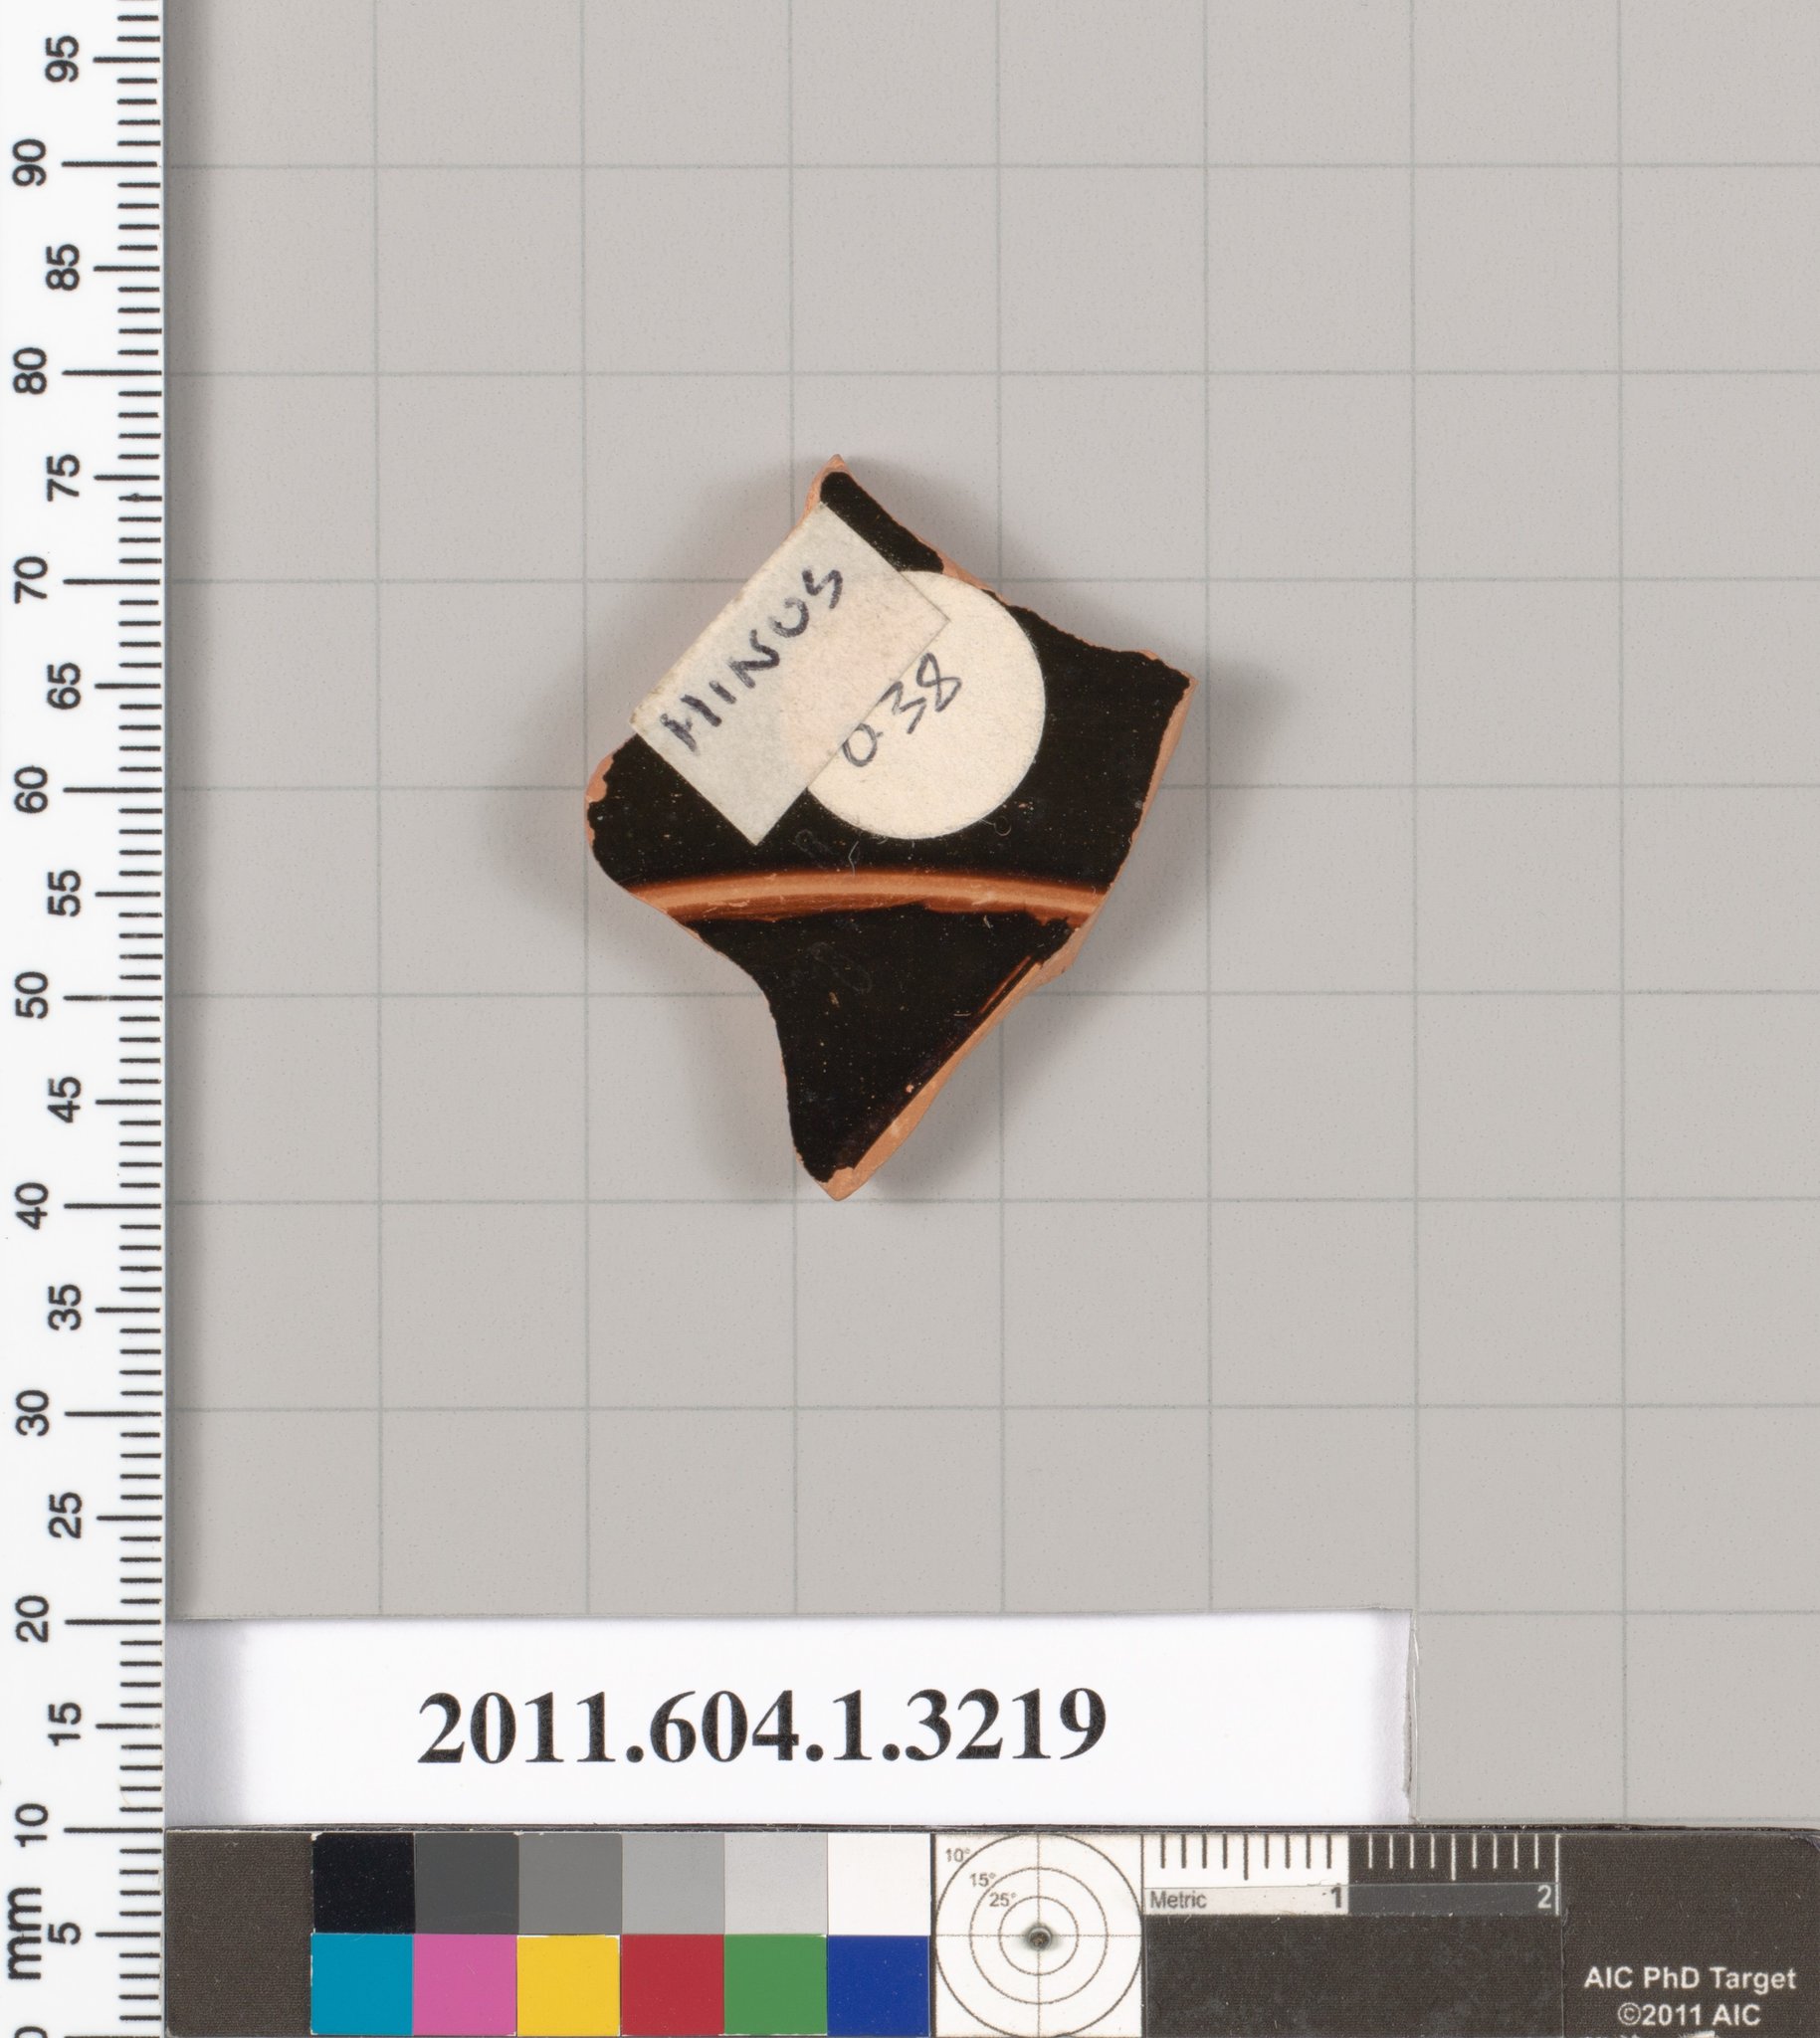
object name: kylix fragment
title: Terracotta fragment of a kylix (drinking cup)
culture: greek, attic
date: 500-451 BCE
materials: terracotta